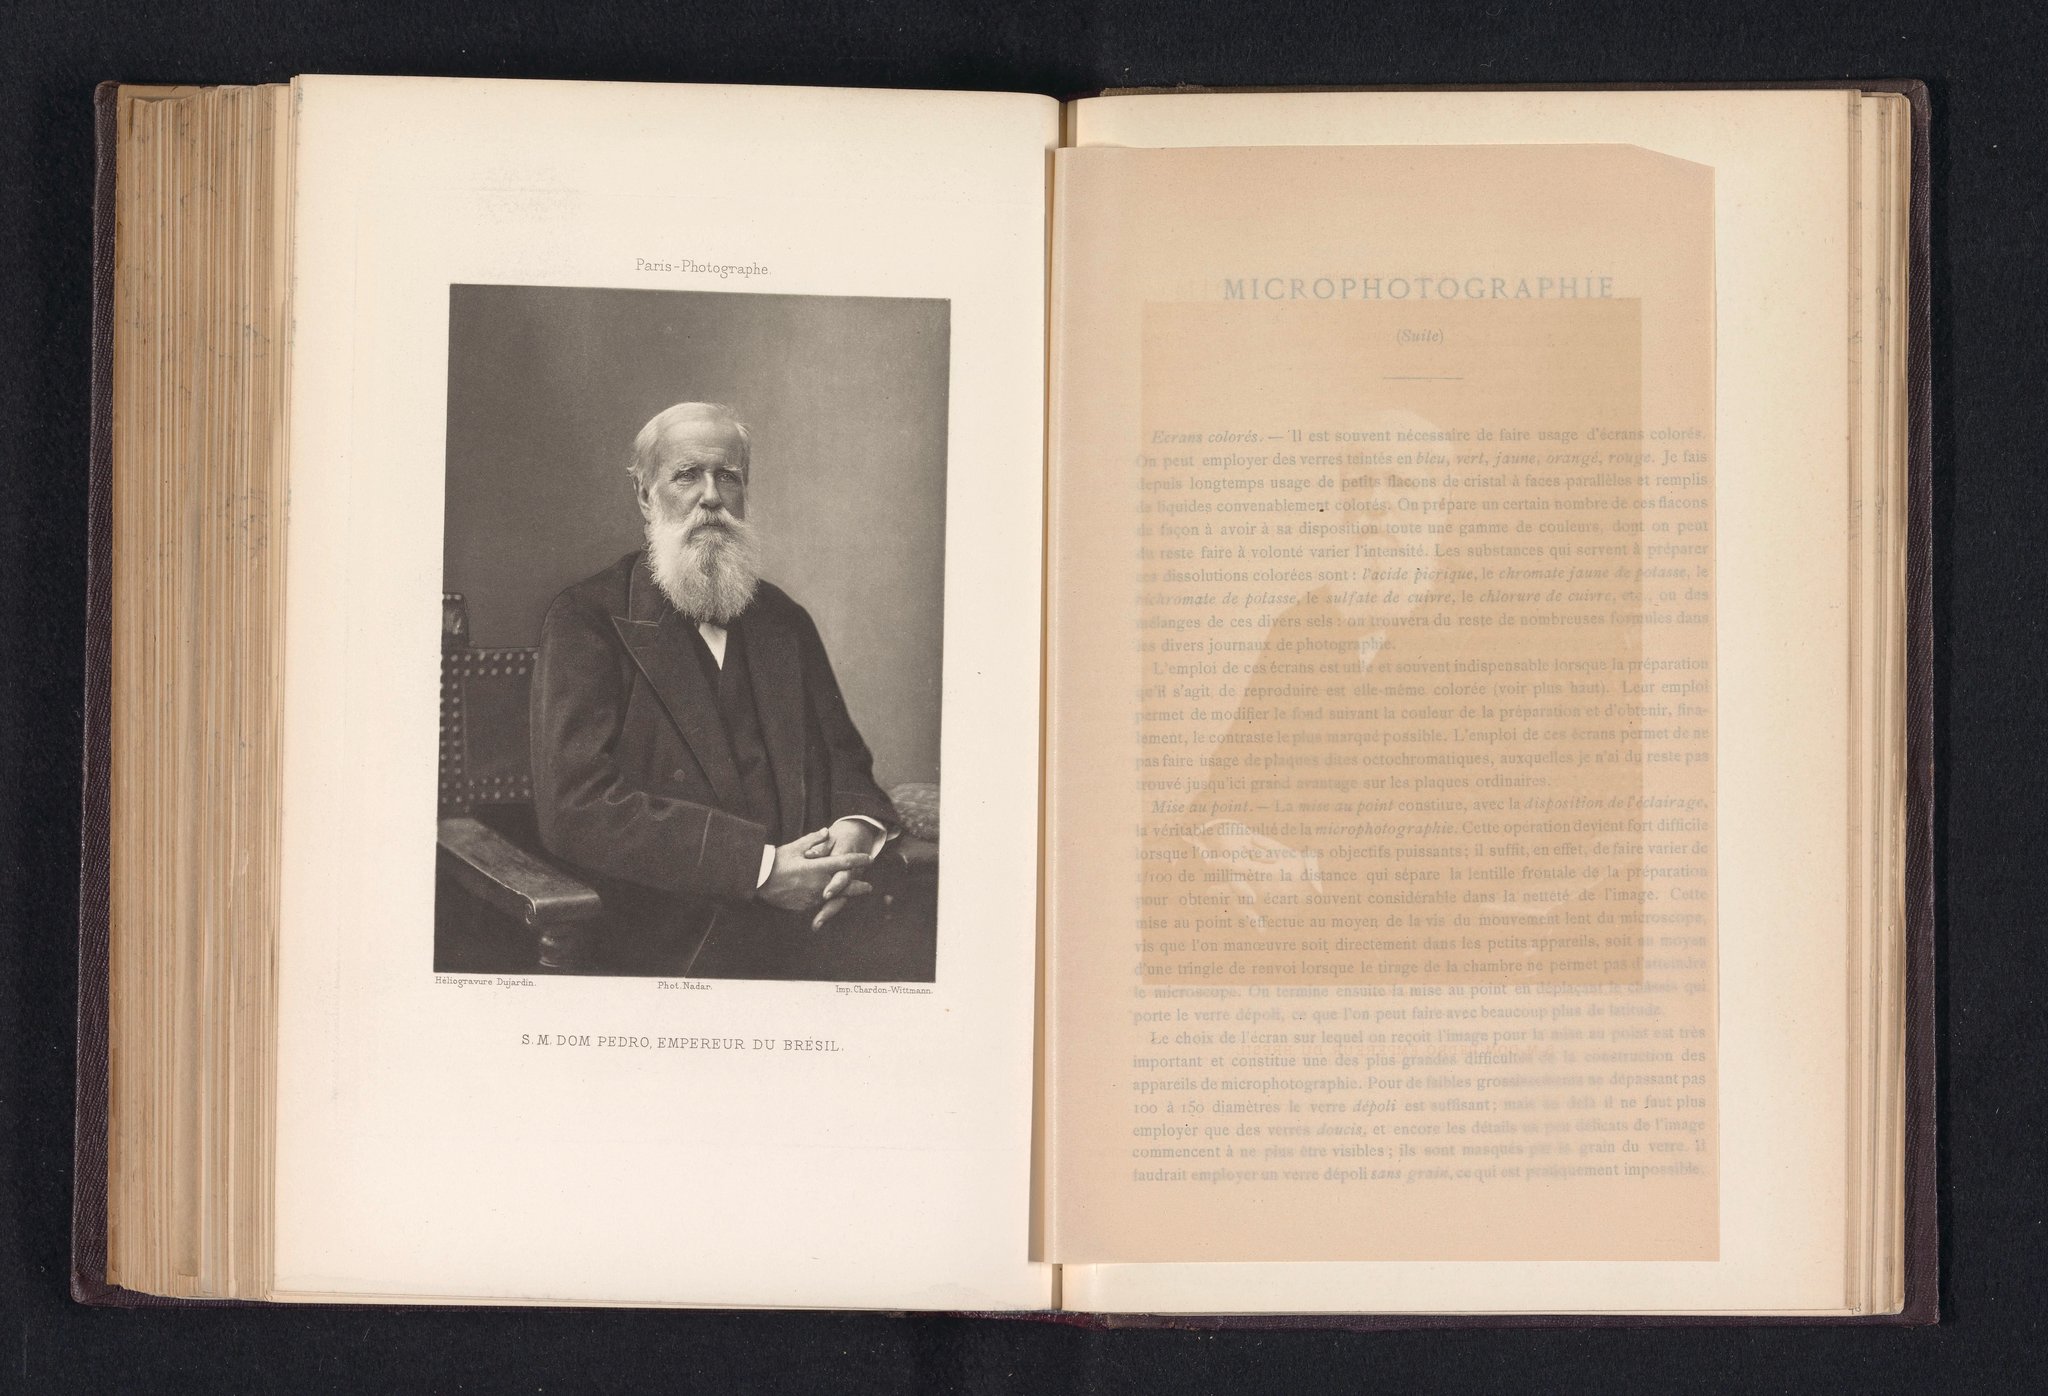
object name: page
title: S.M. Dom Pedro, empereur du Brésil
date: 1881-1891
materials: paper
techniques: photoaquatint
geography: france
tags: ruler, sovereign